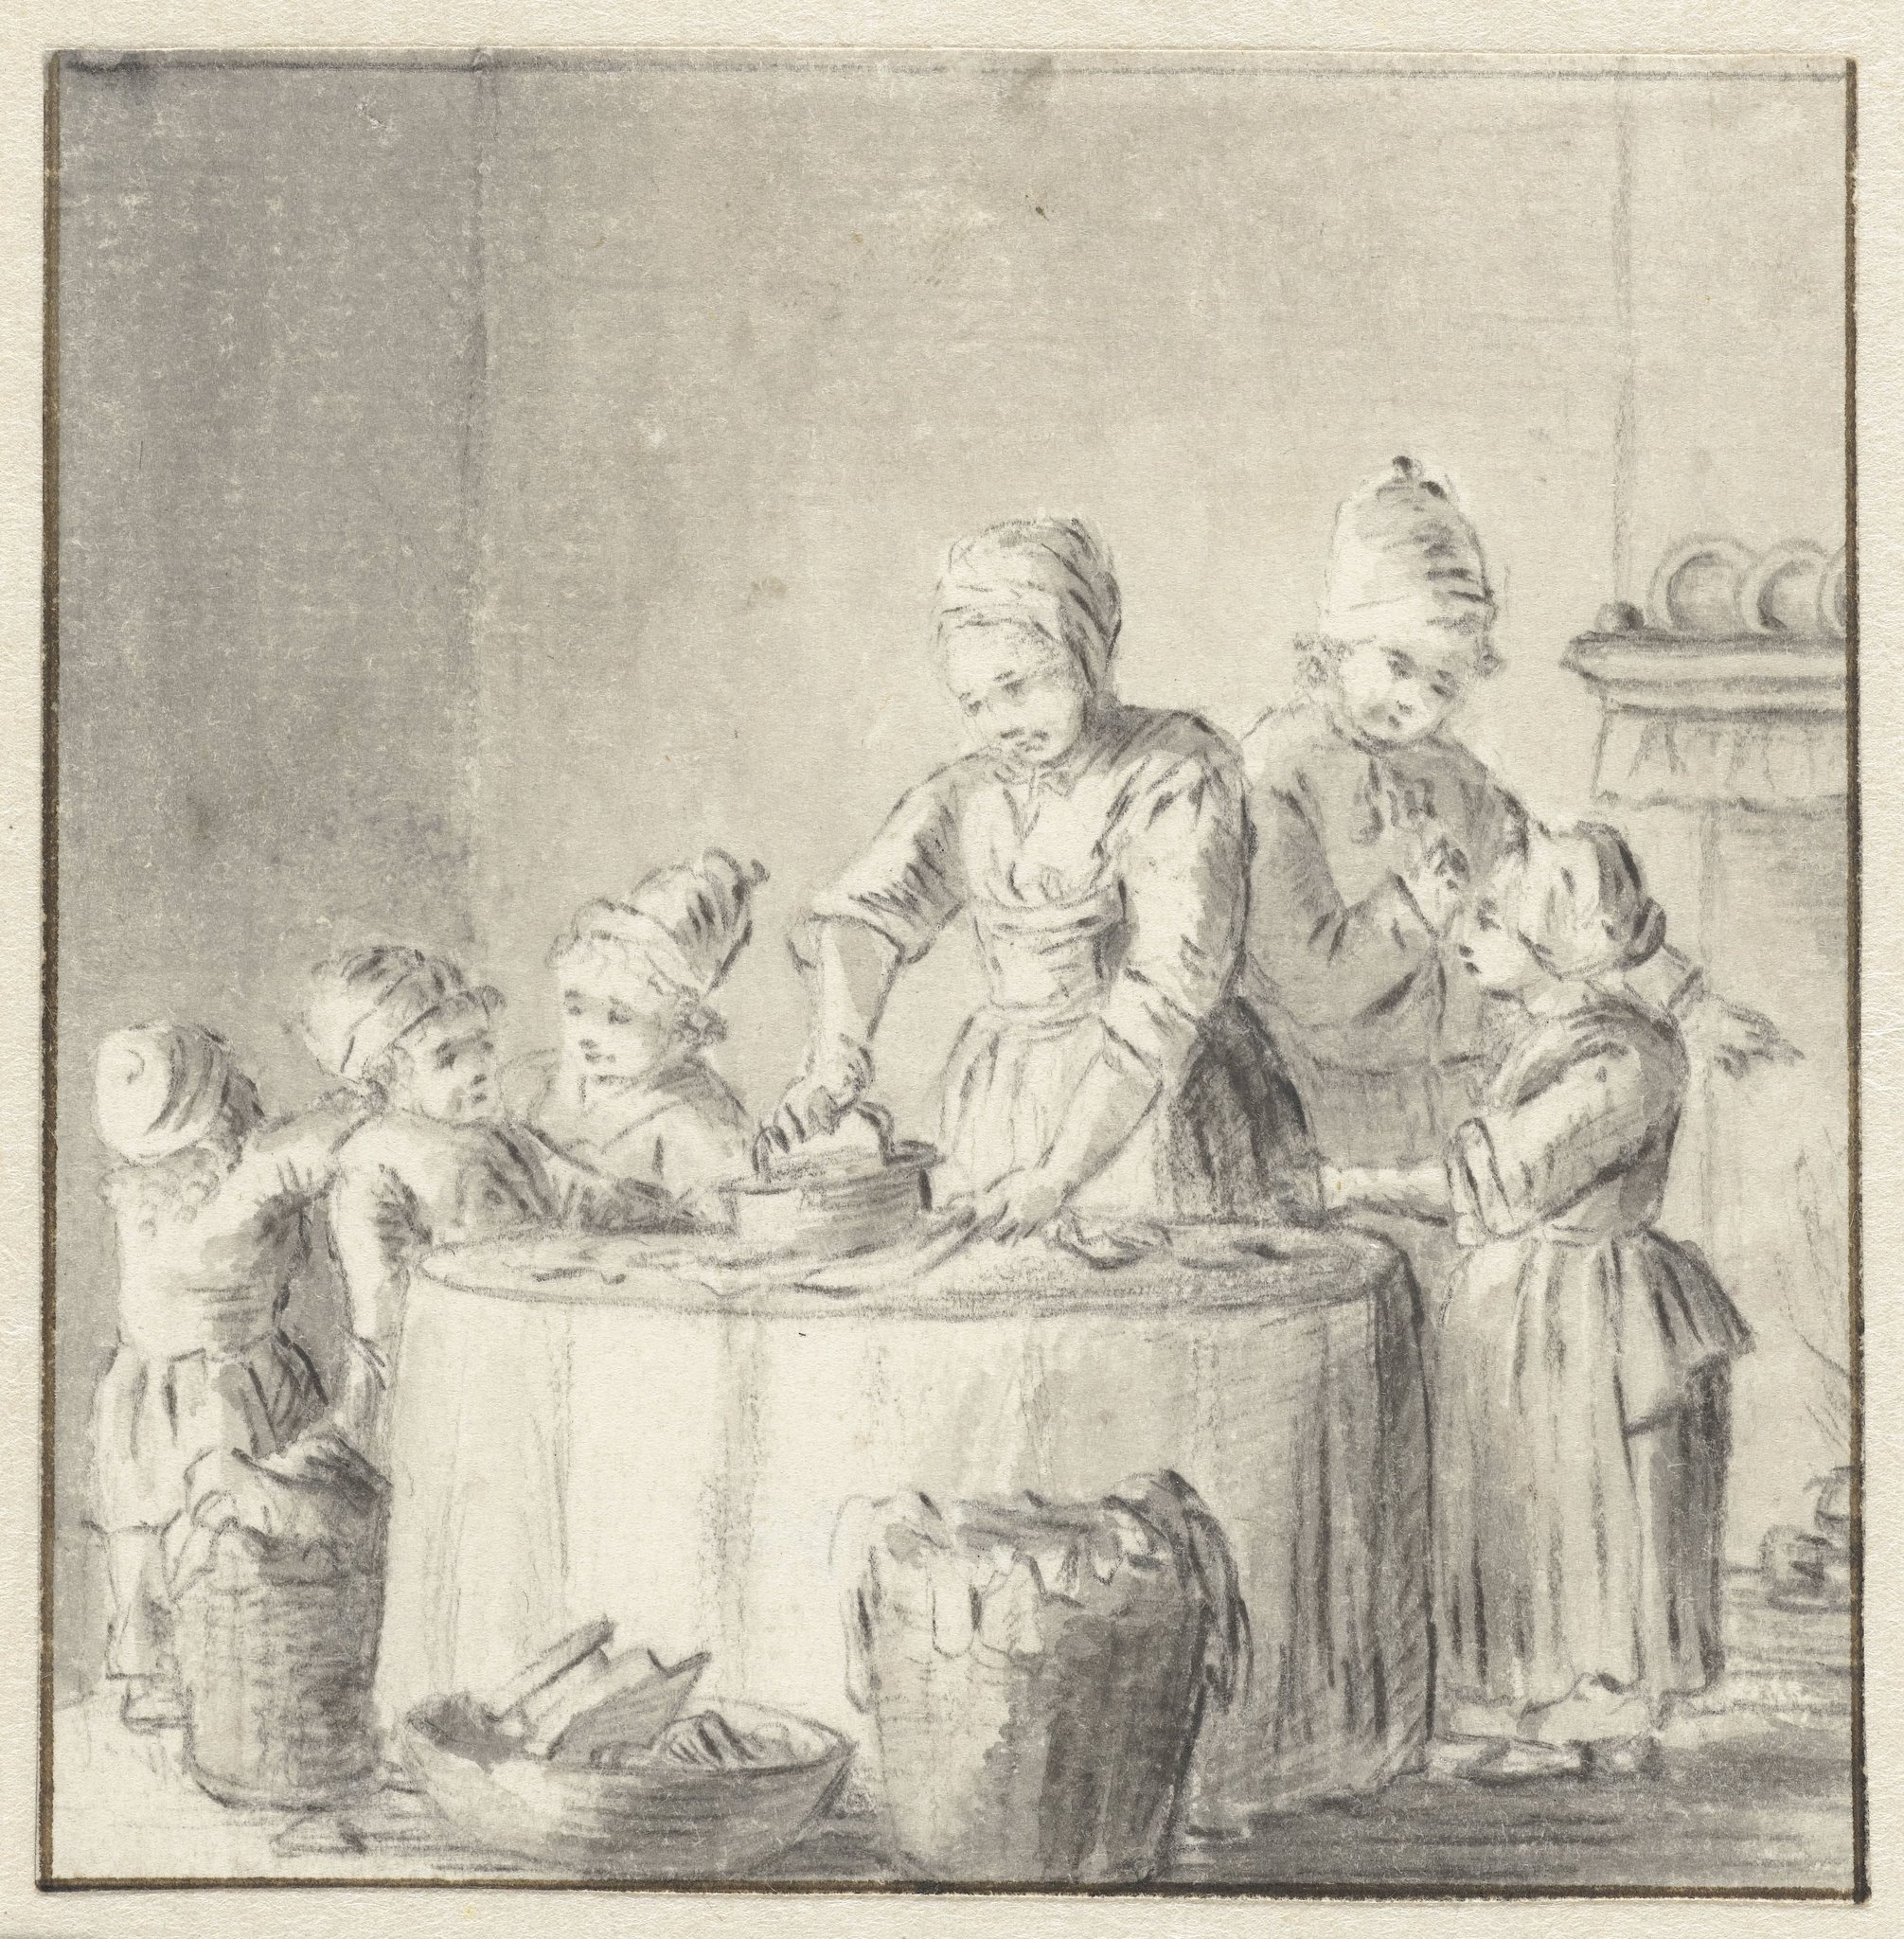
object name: drawing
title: De strijkster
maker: christina chalon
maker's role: draughtsman, print maker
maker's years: 1748-1808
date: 1758-1808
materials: chalk, paper, pencil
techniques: brush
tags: ironing